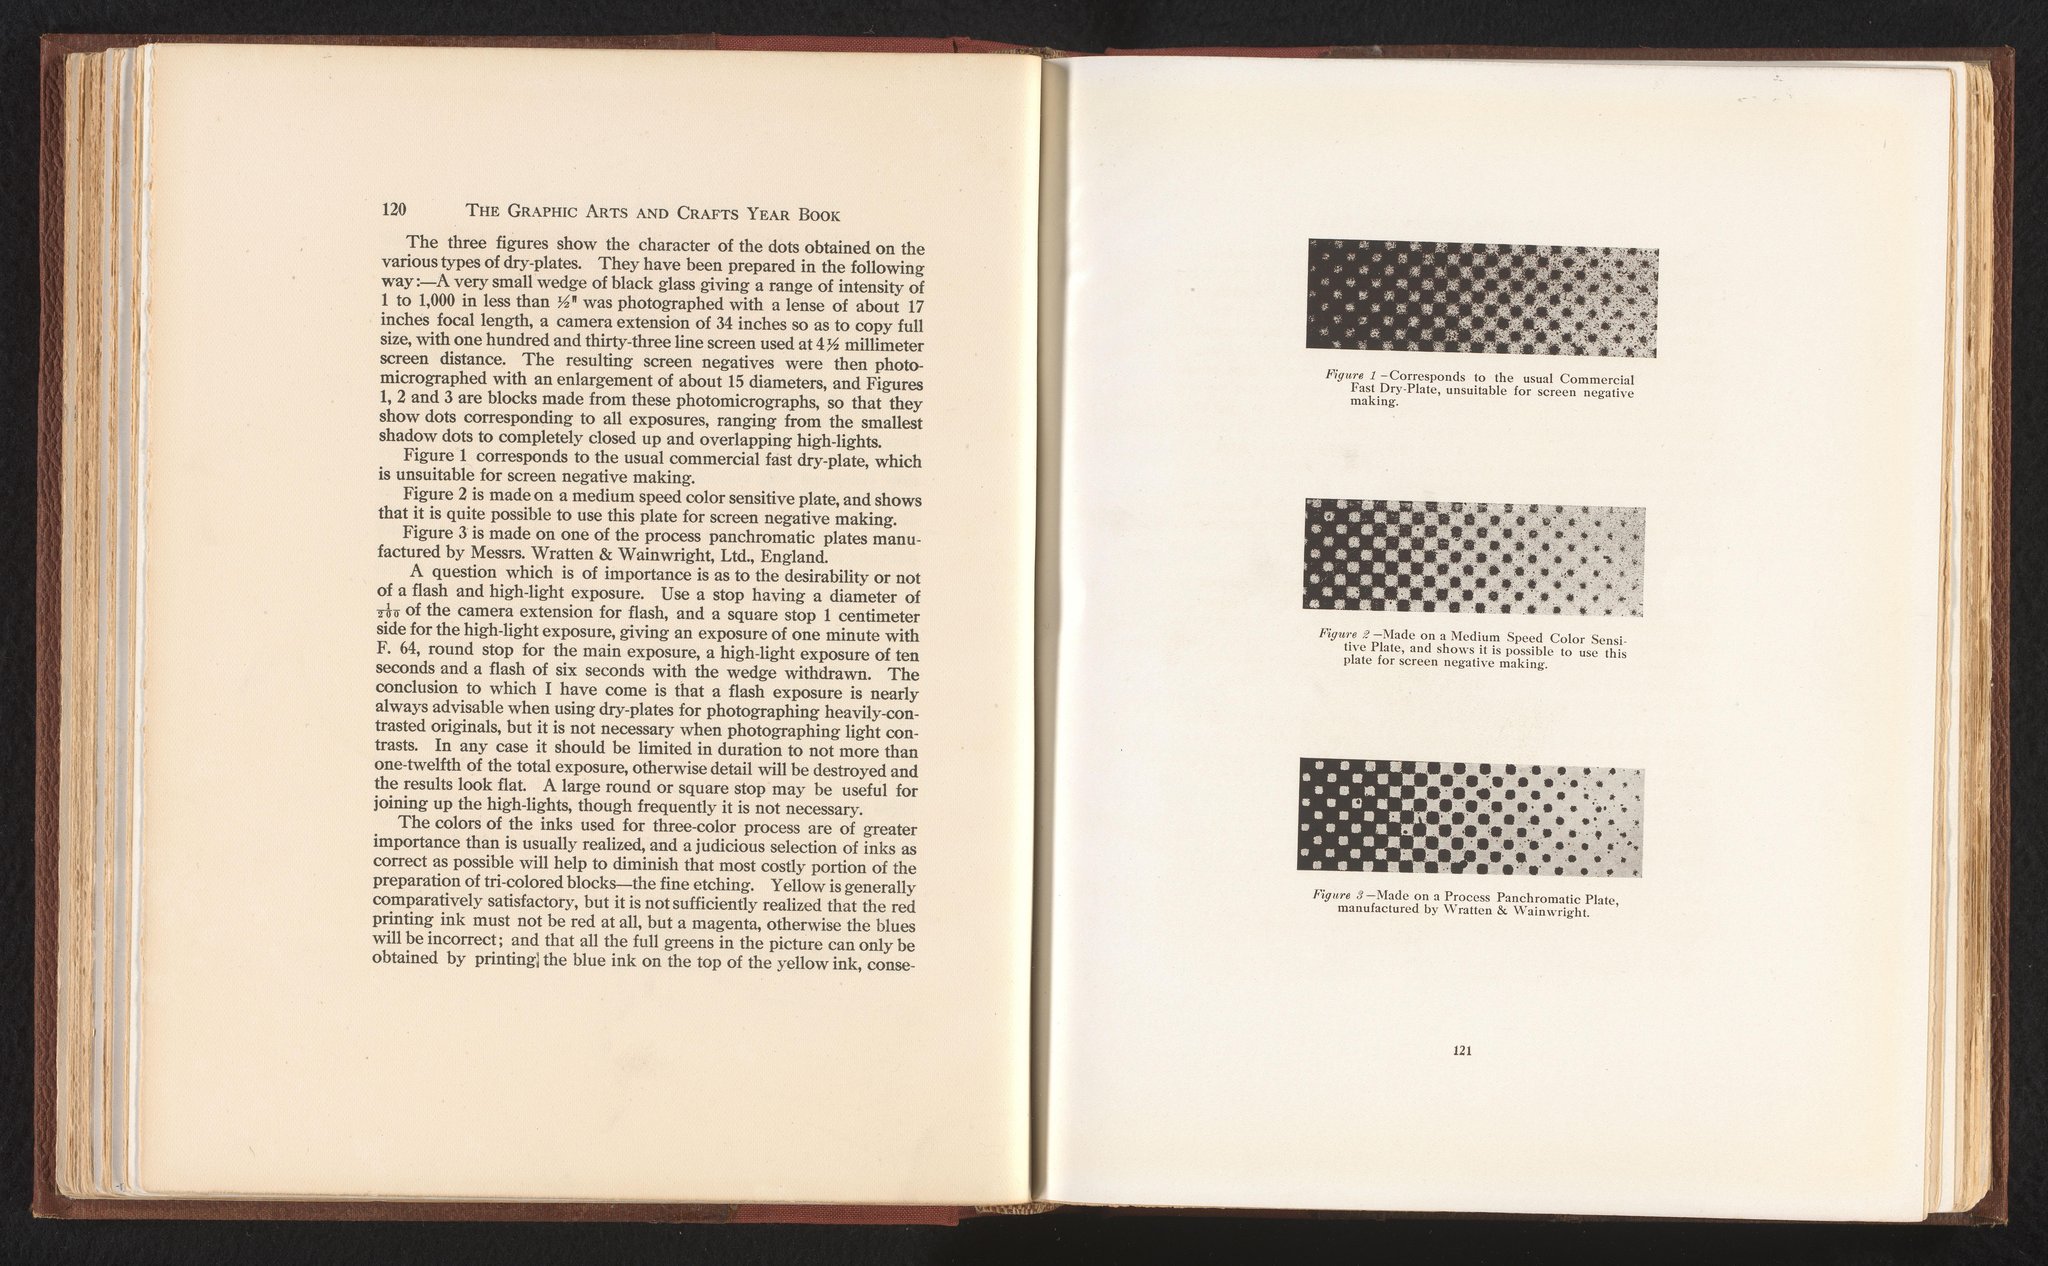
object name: reproduction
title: Reproductie van drie uitvergrotingen van het fotomechanische reliëfdrukprocedé autotypie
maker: Anonymous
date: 1904-1909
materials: paper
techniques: autotype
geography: london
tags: printed matter